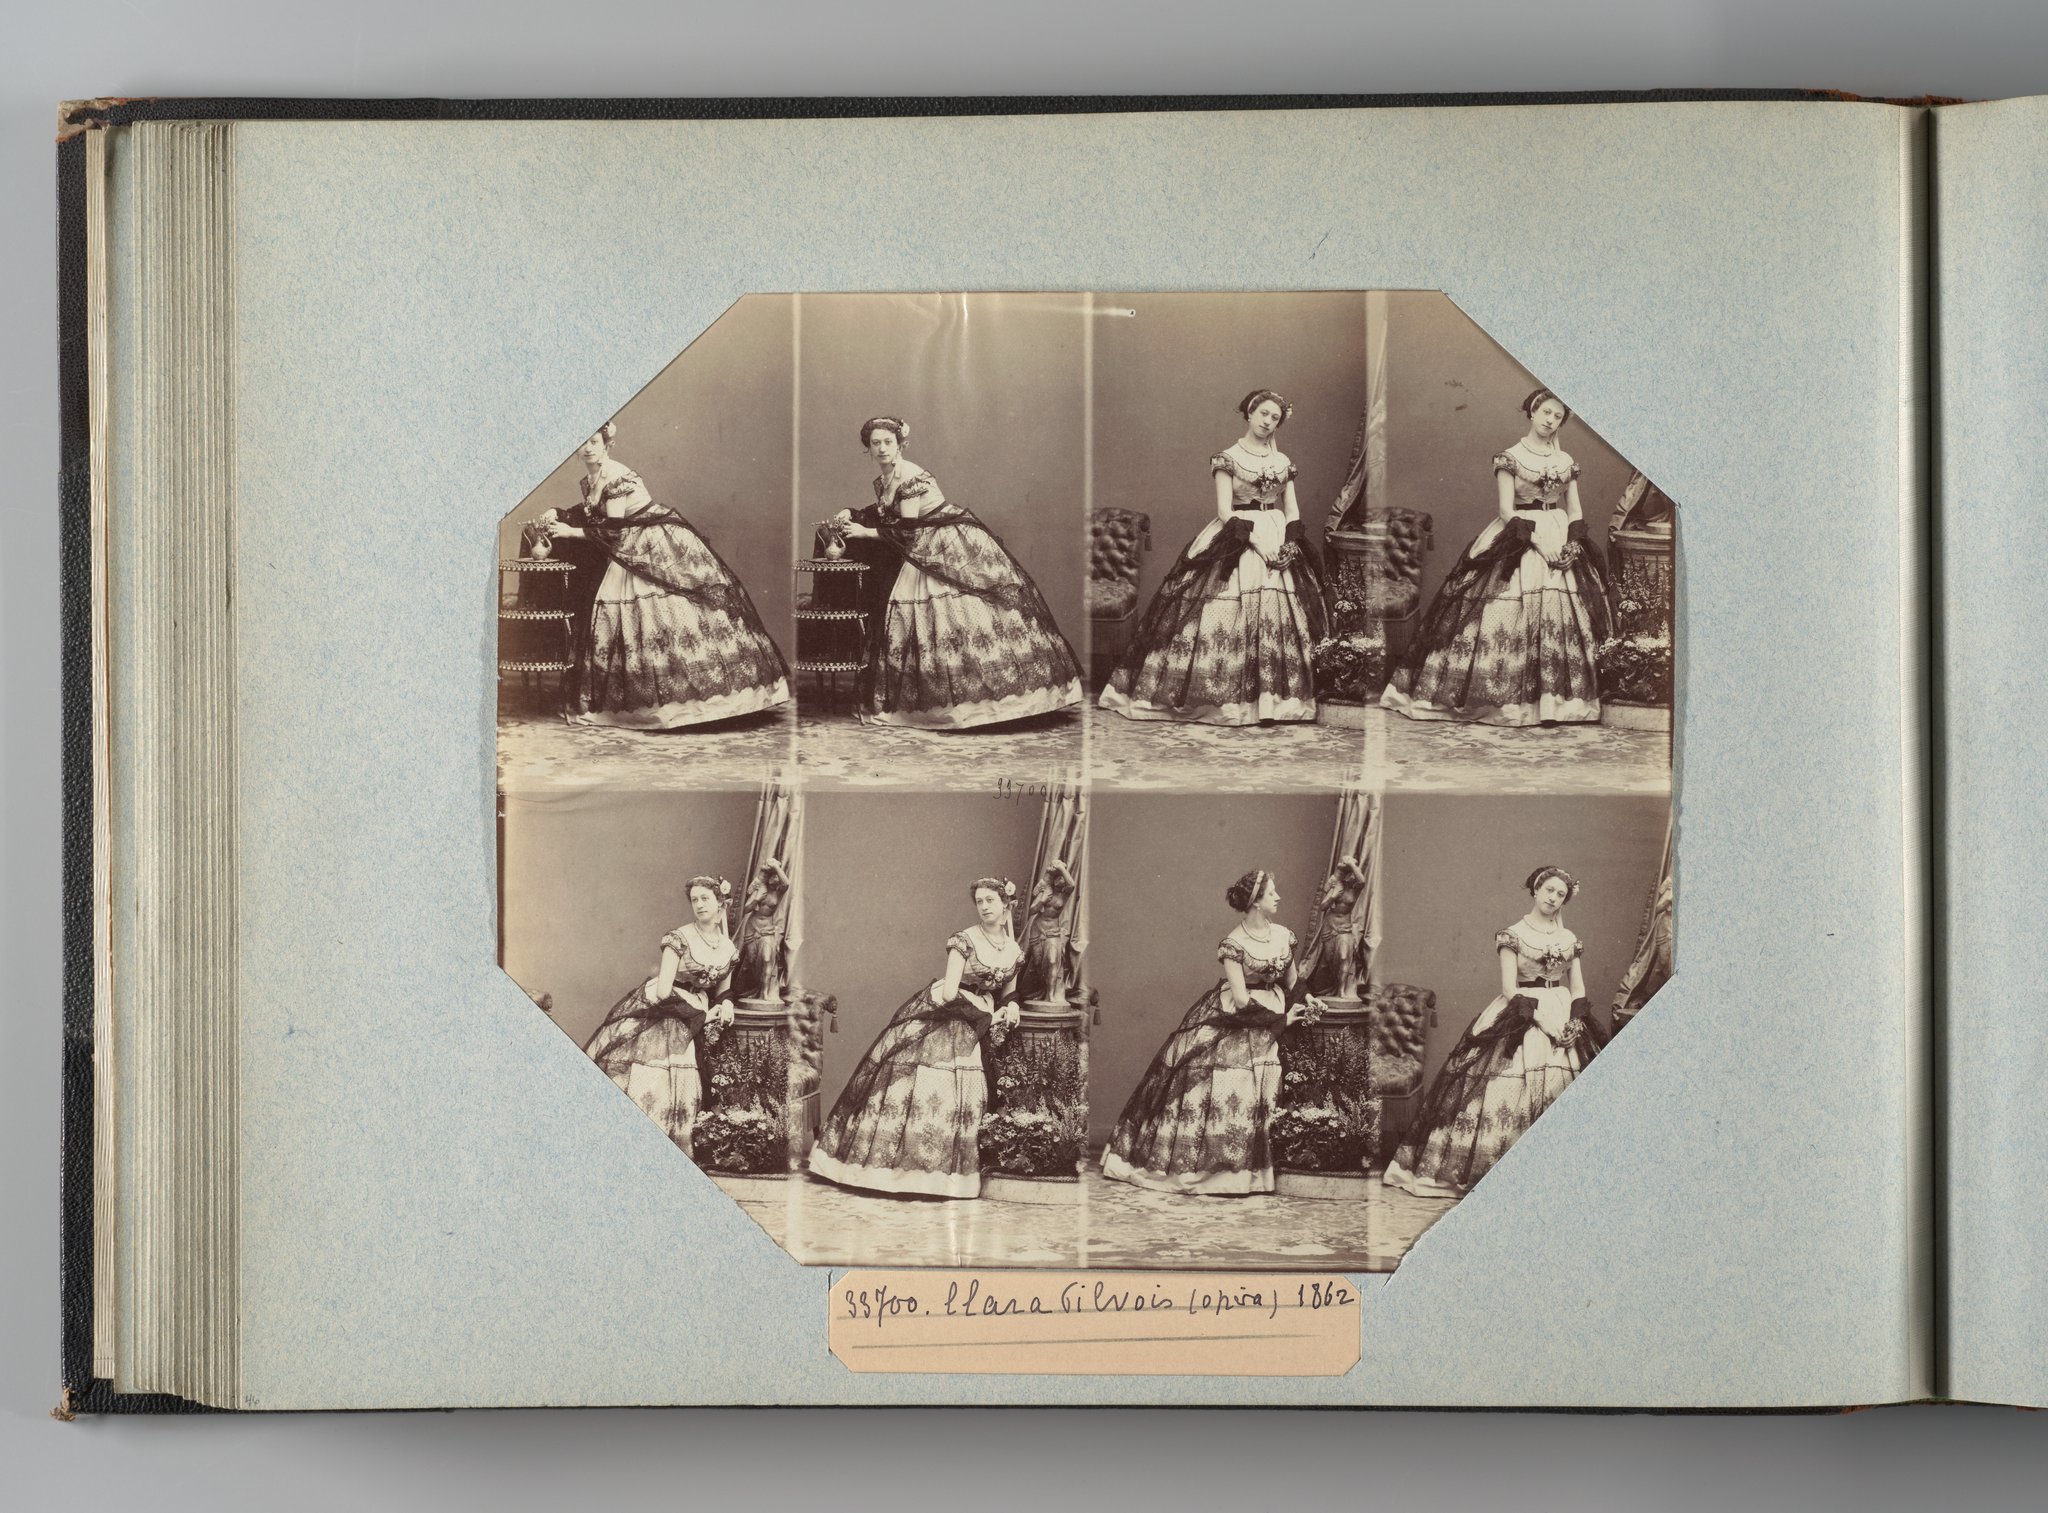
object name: photograph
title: Clara Pilvois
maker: andré-adolphe-eugène disdéri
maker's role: artist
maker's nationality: french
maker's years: 1819-1889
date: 1862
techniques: albumen silver print, glass negative